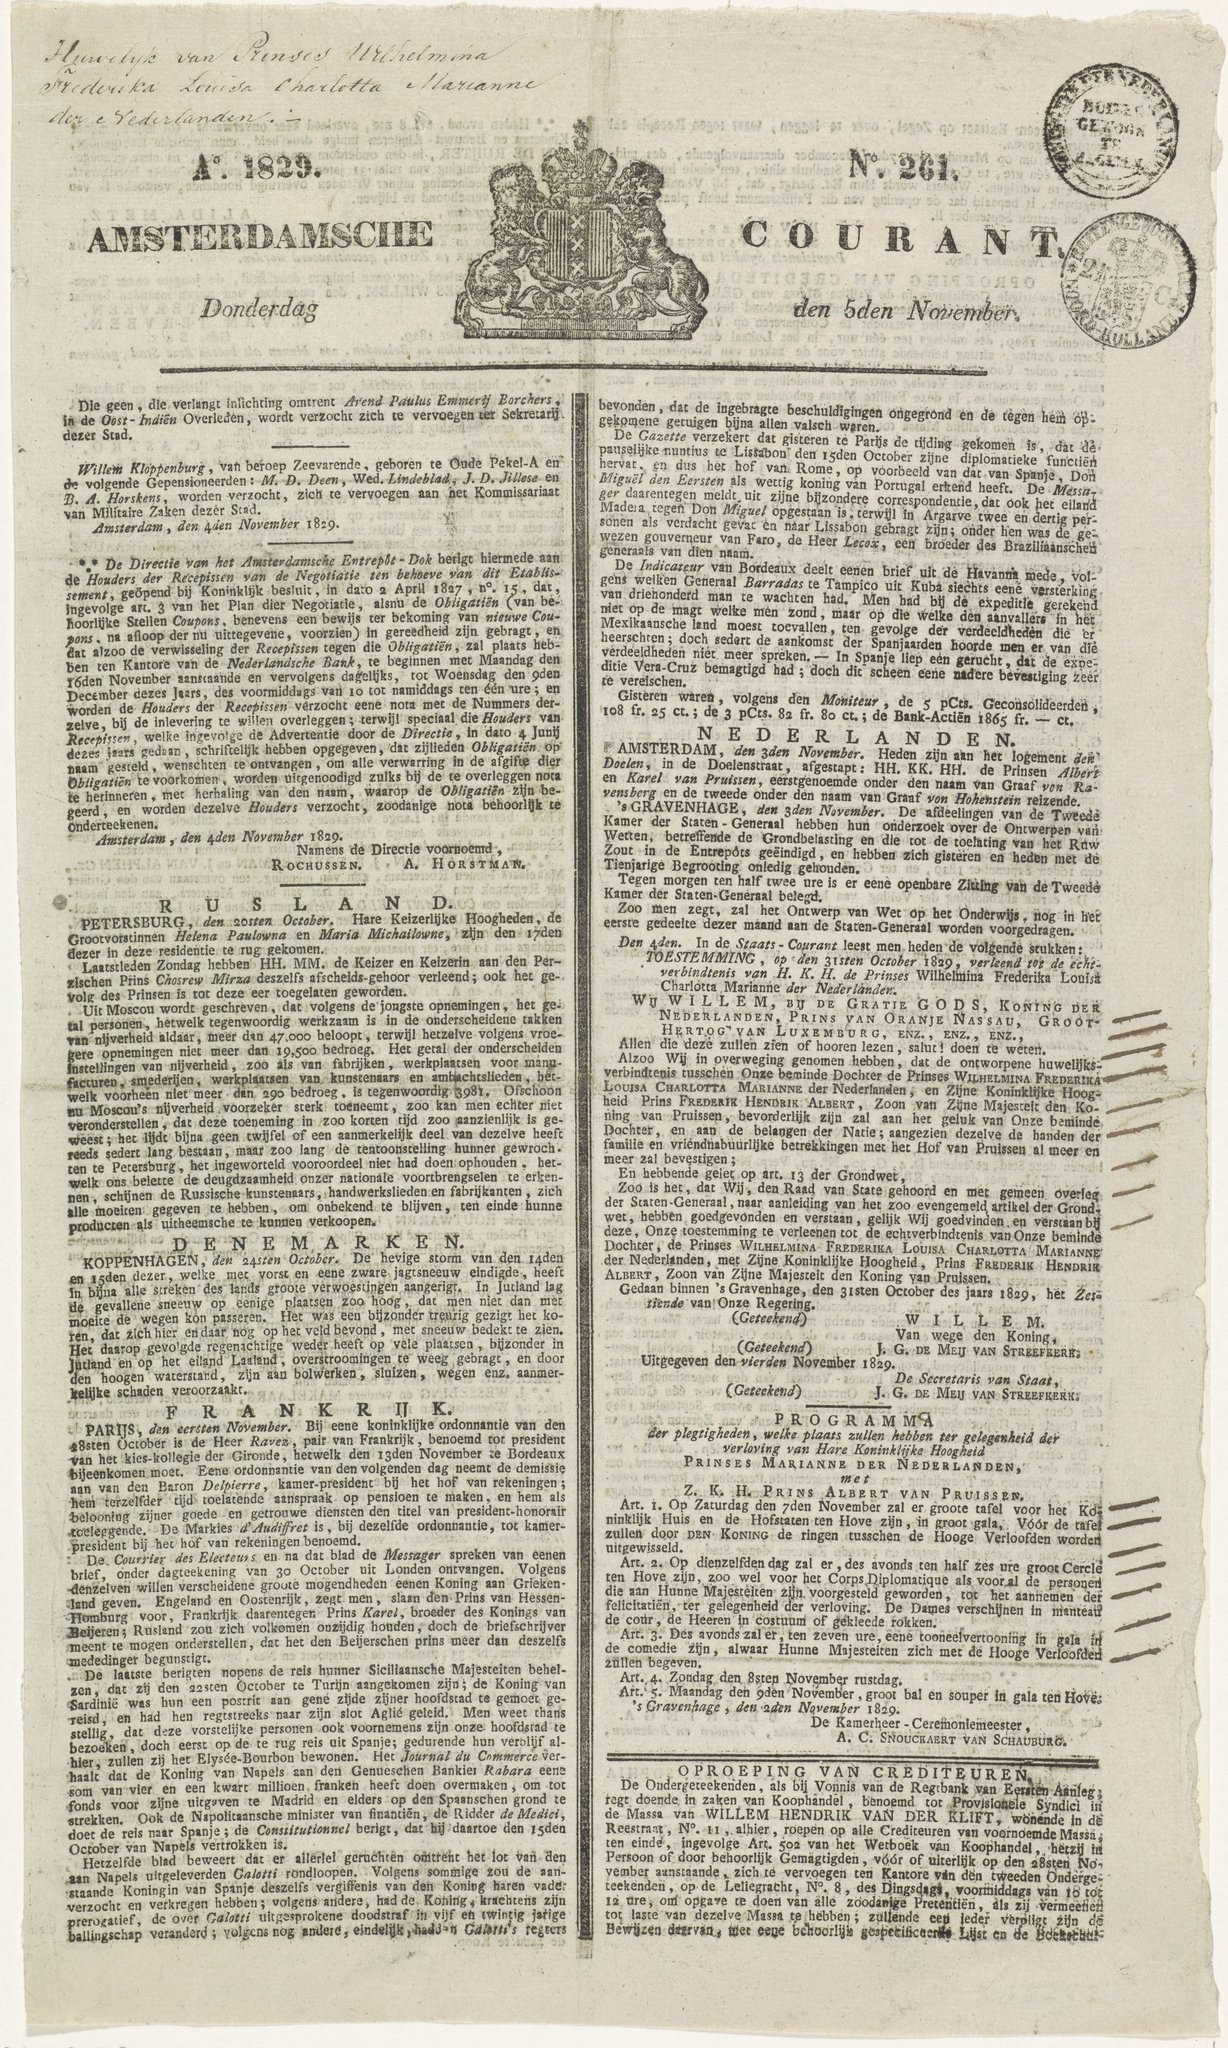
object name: newspaper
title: Amsterdamsche Courant. Donderdag den 5den November. Ao. 1829. No. 261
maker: Anonymous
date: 1829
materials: paper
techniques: letterpress printing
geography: amsterdam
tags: berlin, voorburg, marianne (prinses der nederlanden), the hague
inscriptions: collector's mark: Lugt 2228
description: Aflevering van de Amsterdamsche Courant van 5 november 1829 met het nieuws van de verloving van Prinses Marianne met prins Albert van Pruisen op 31 oktober 1829 en het programma van de feestelijkheden die zullen plaatsvinden in Den Haag ter gelegenheid van de verloving. Blad bedrukt op beide zijden, bovenaan een vignet van het stadswapen.